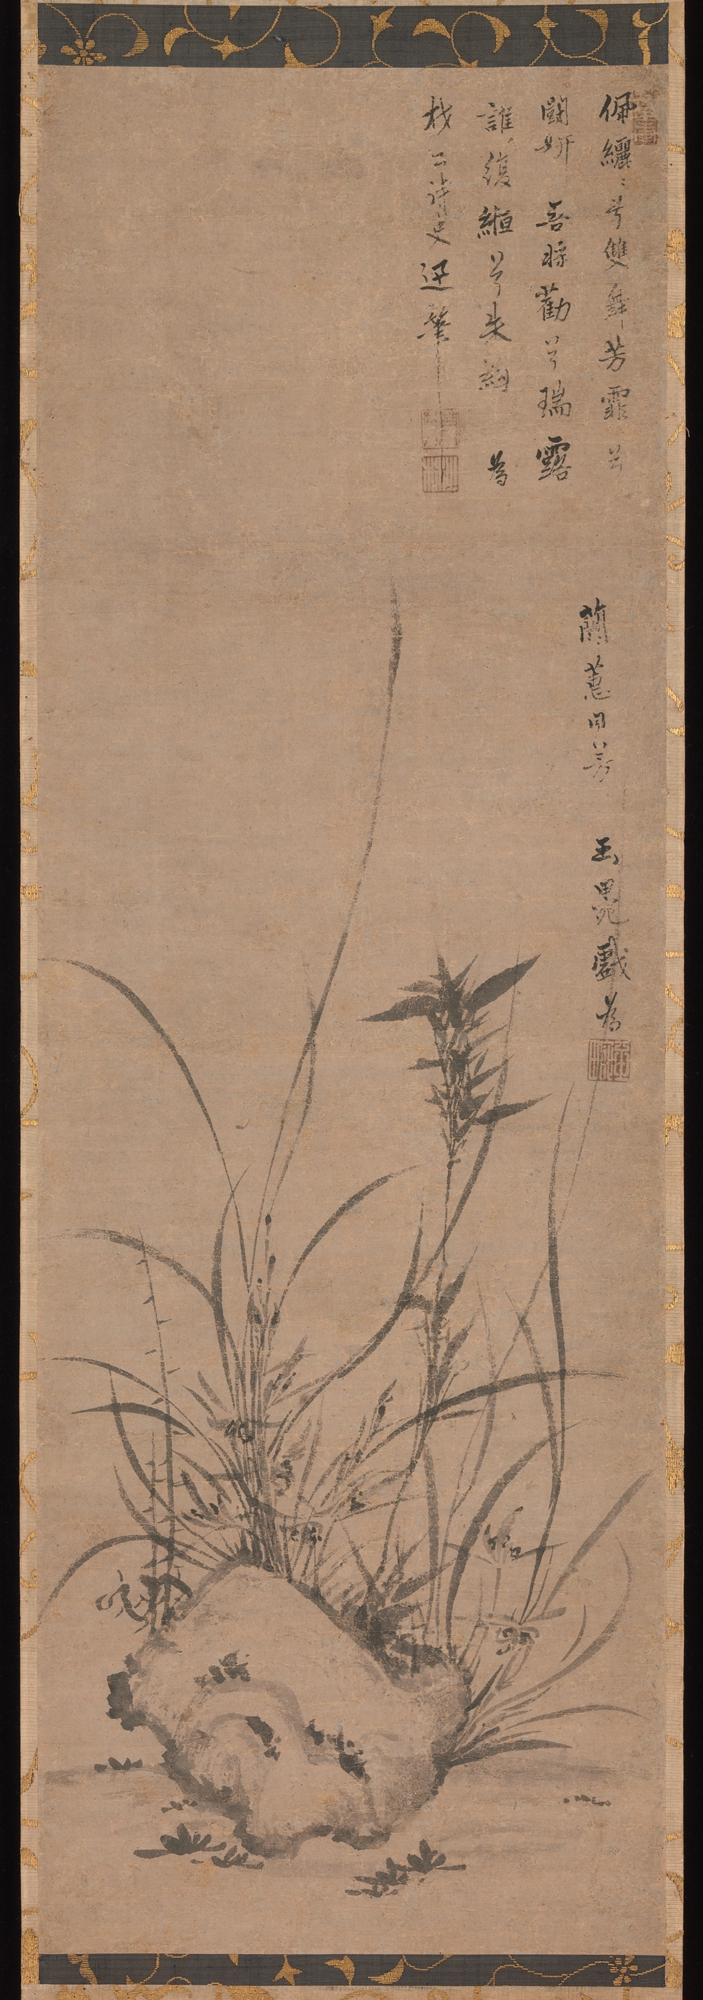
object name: hanging scroll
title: Orchids and Rock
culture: japanese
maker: gyokuen bonpō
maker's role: artist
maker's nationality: japanese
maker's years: 1348-1420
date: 1367-1433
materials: ink, paper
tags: orchids